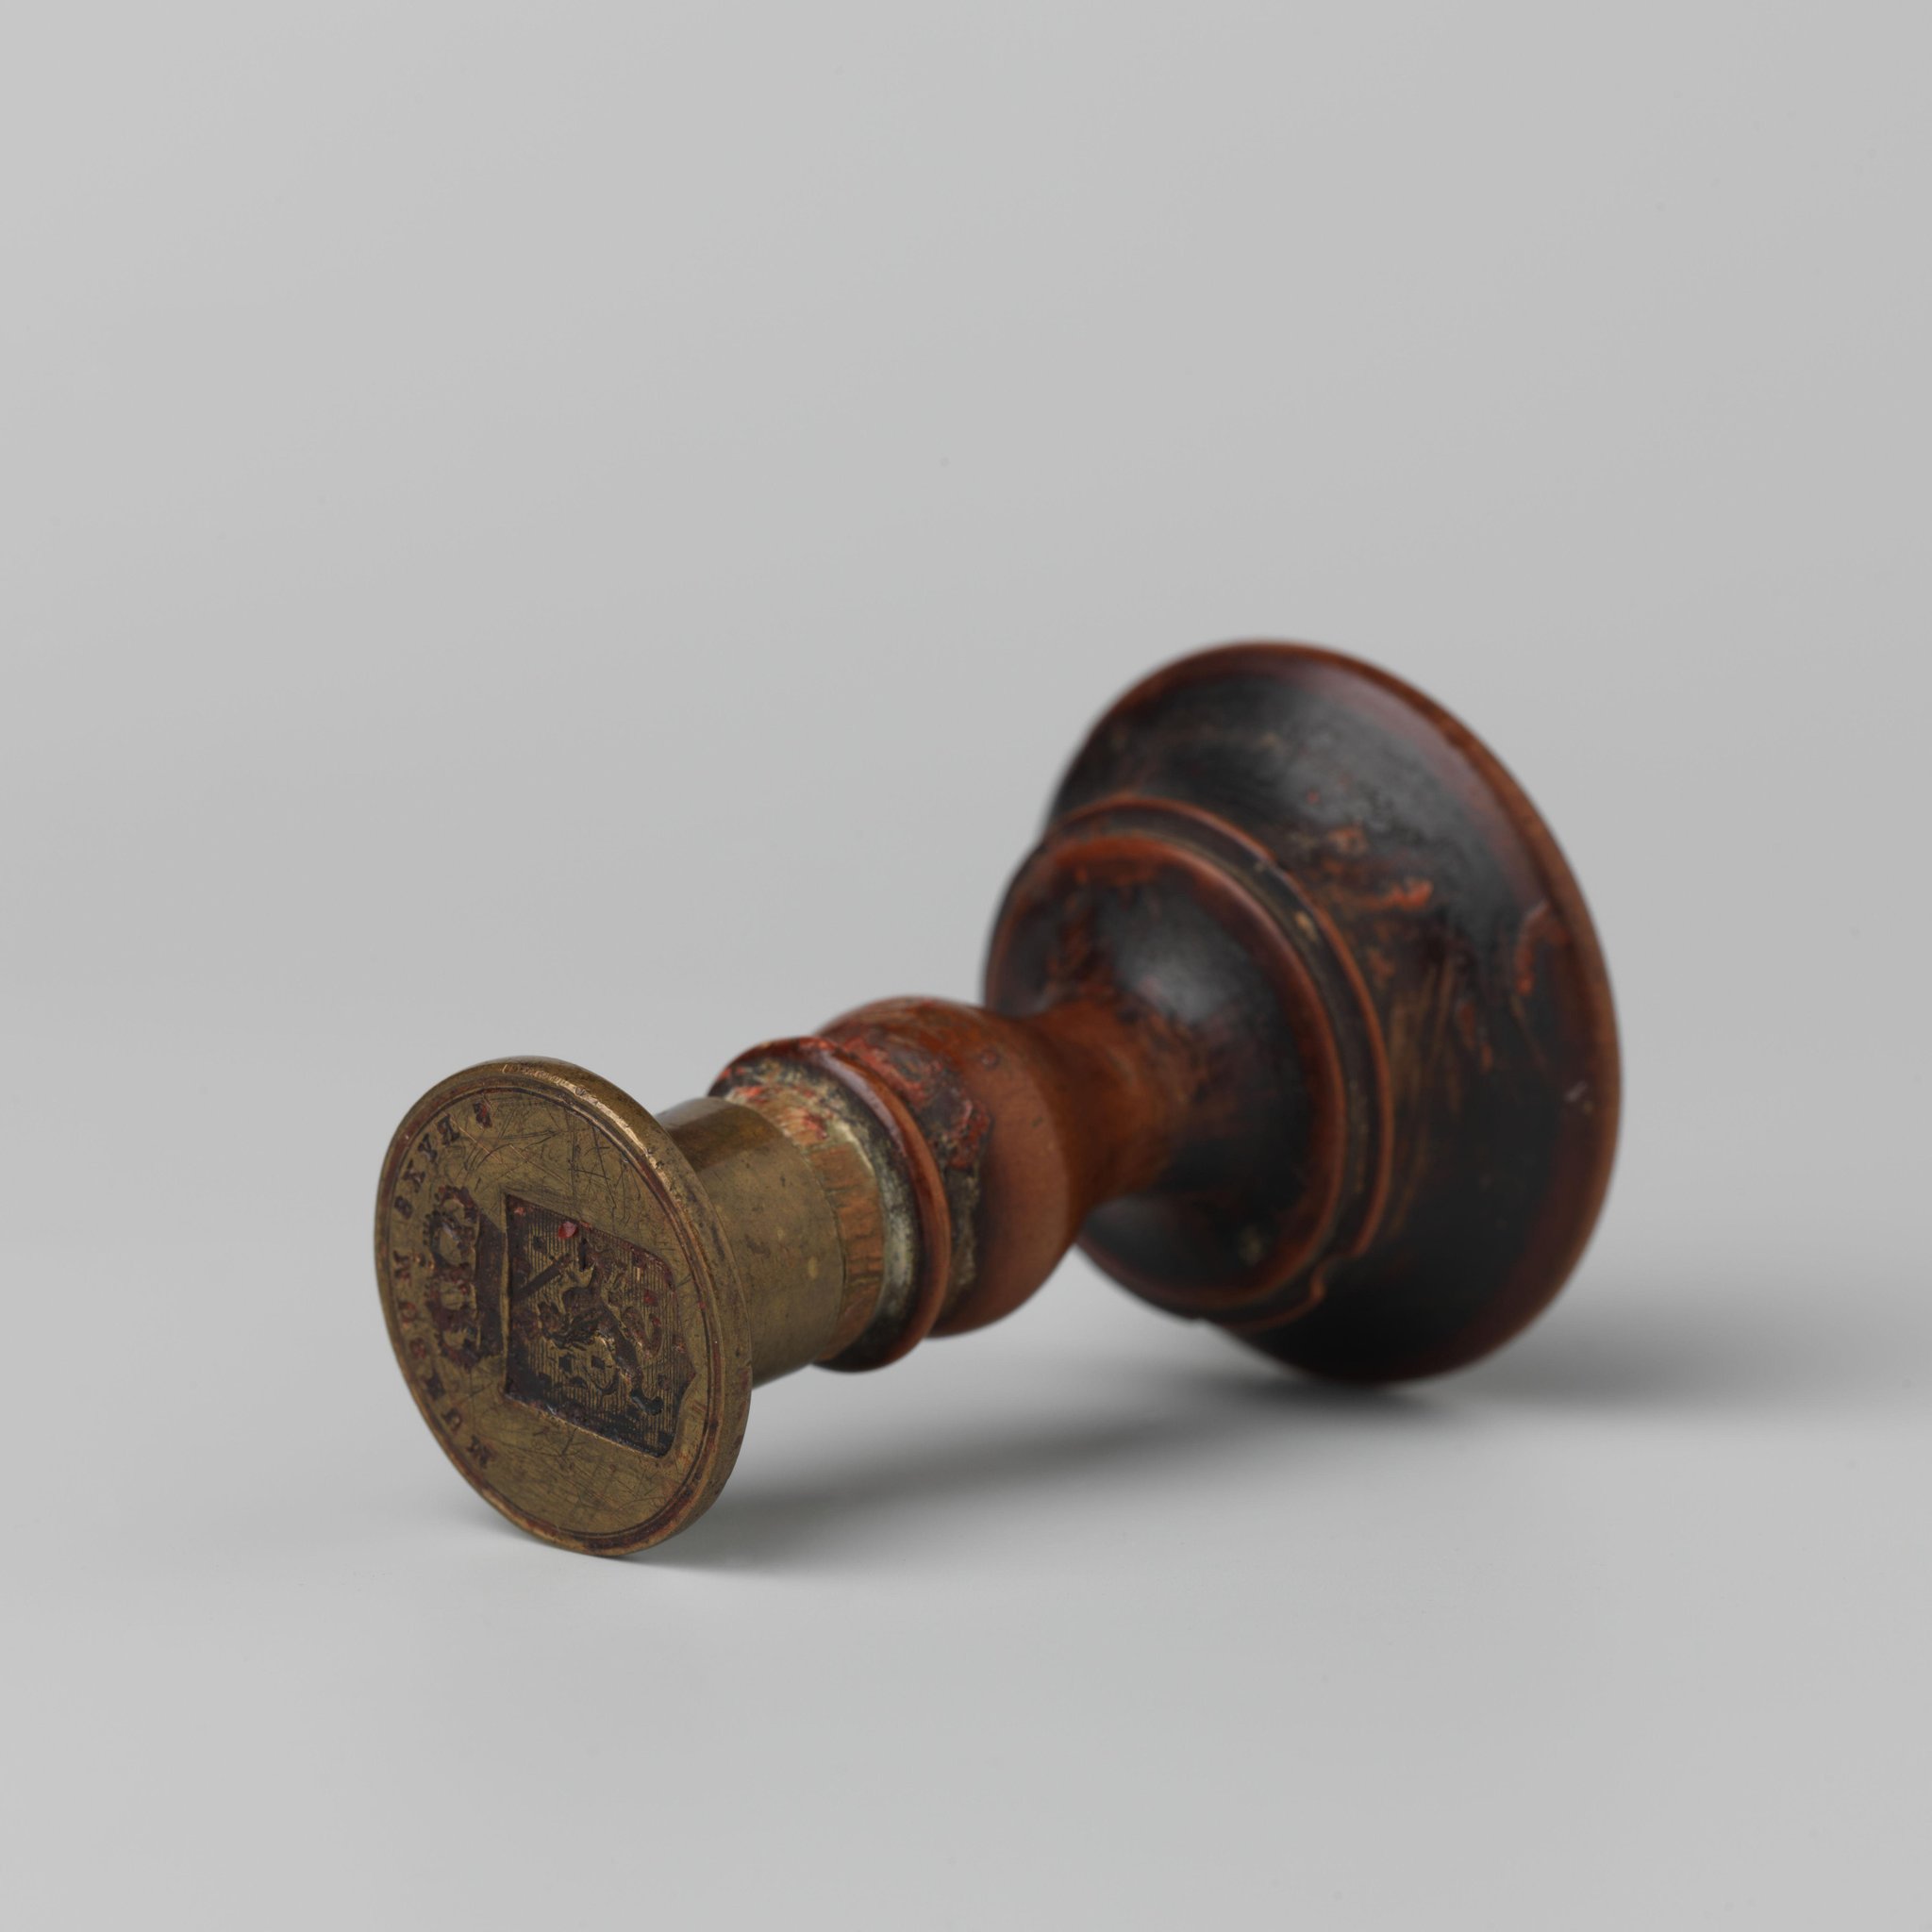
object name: zegelstempel, lakstempel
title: Zegelstempel van het Rijksmuseum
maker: Anonymous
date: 1850-1900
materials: brass, wood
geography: netherlands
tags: rijksmuseum amsterdam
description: Zegelstempel gebruikt door het Rijksmuseum om documenten met lakzegels te bekrachtigen.